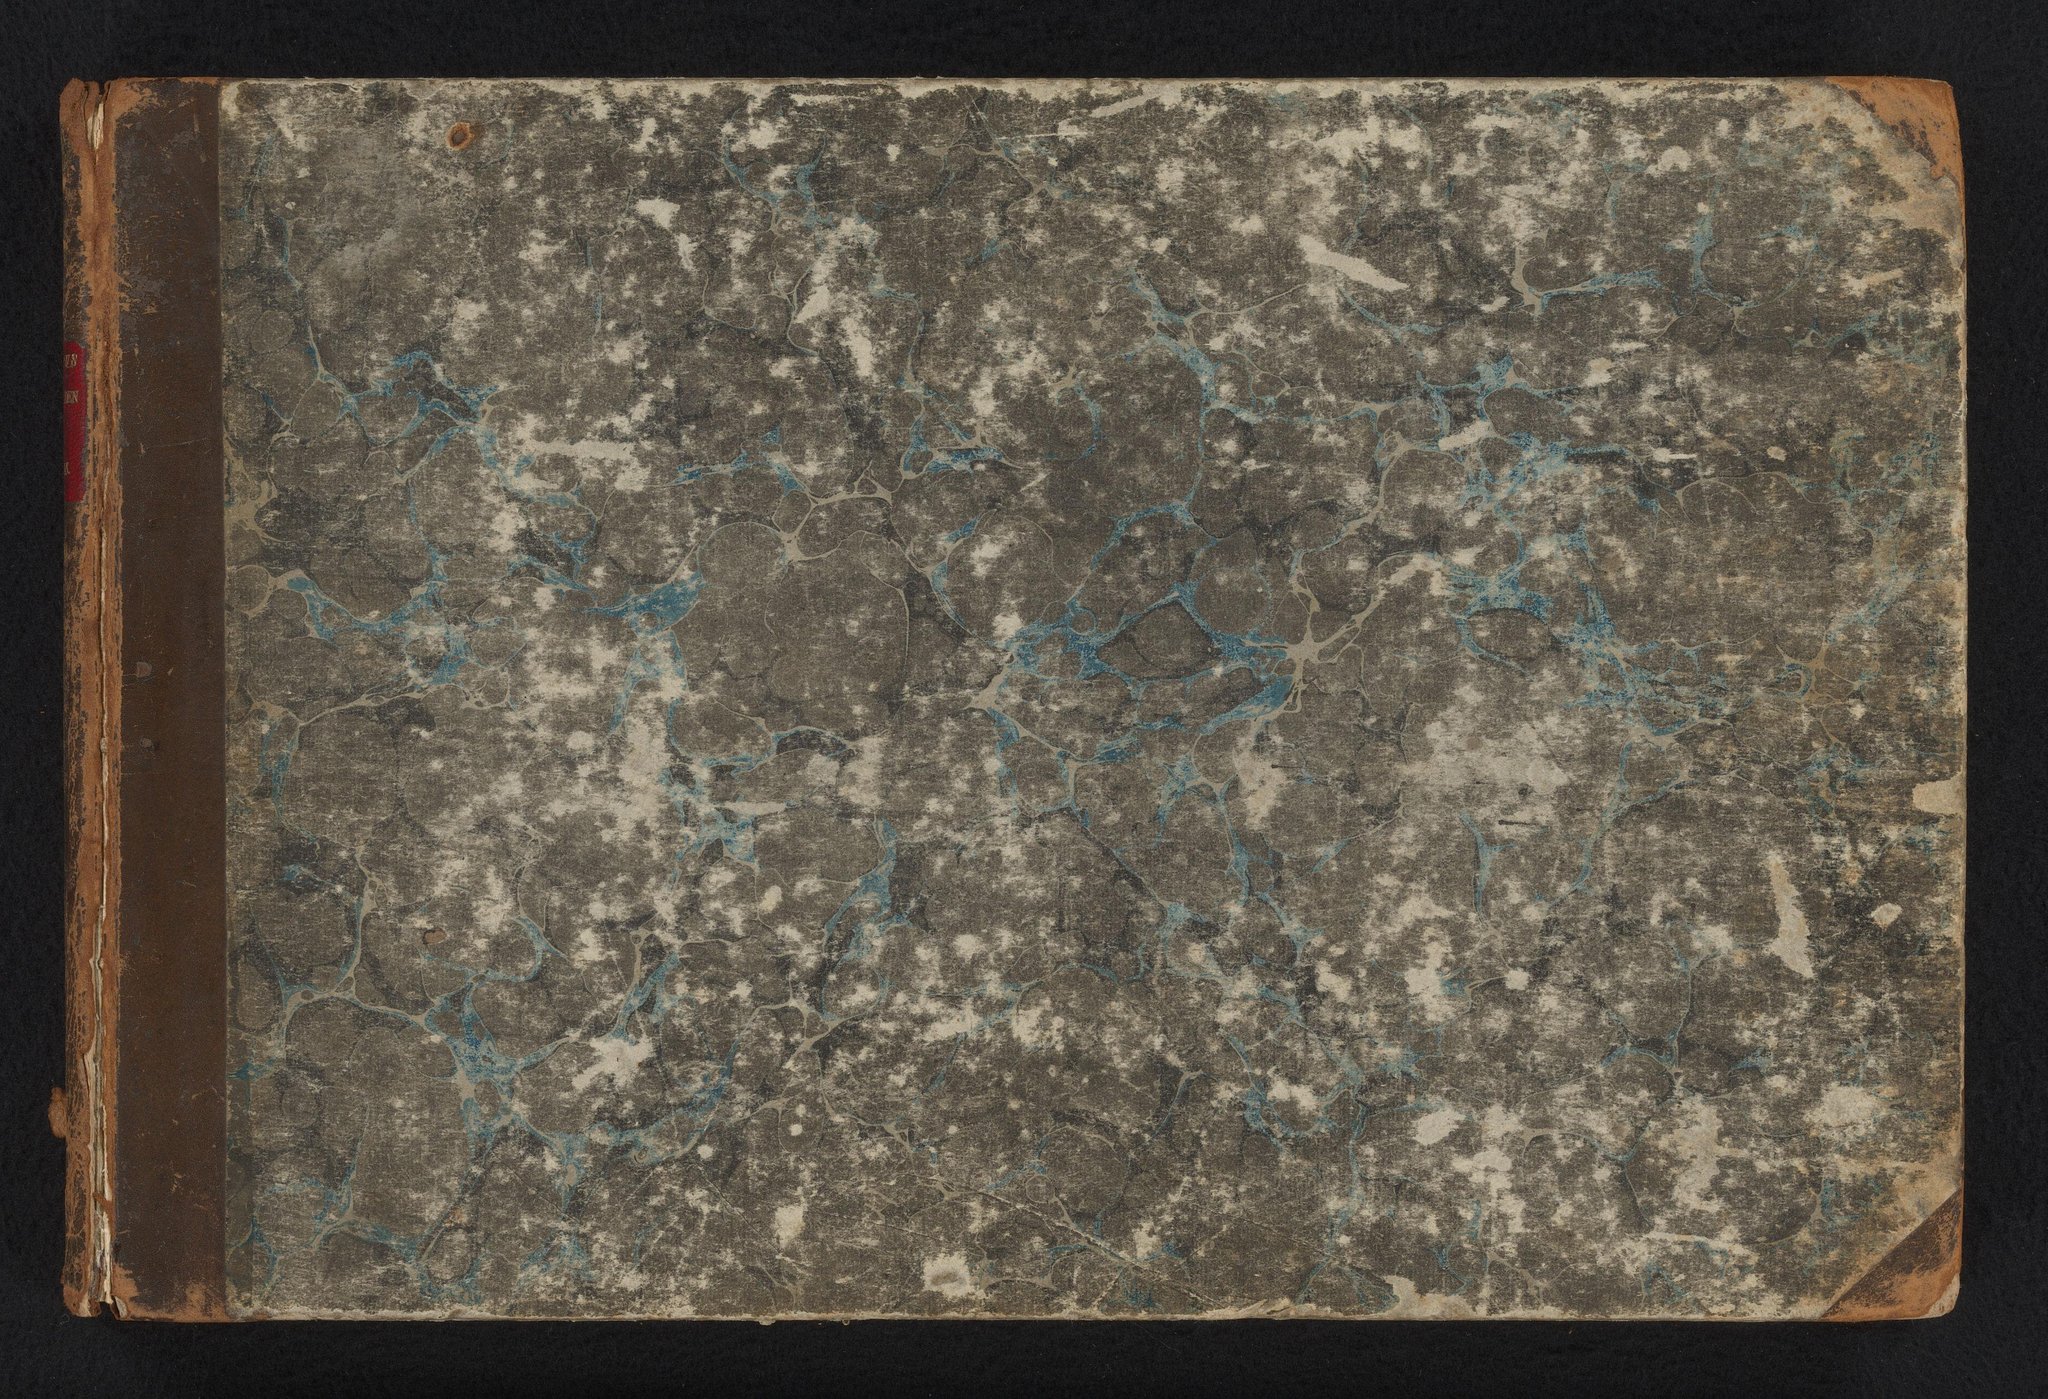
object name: letter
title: Studiebeelden en fragmenten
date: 1807-1816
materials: leather, cardboard, ink, paper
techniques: aquatint, bookbinding, printing, etching, letterpress printing, marbling, marbled paper, writing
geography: amsterdam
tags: print, e.g.: engraving, etching, lithograph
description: Album met daarin de complete reeks van 105 prenten getiteld: 'Studiebeelden en fragmenten, na het leven geteekend en in het koper gebracht door Jacob Ernst Marcus'. Op het schutblad een handgeschreven brief van Marcus aan de heer De Bast. Los ingelegd portret van Jacob Ernst Marcus door Bagelaar.